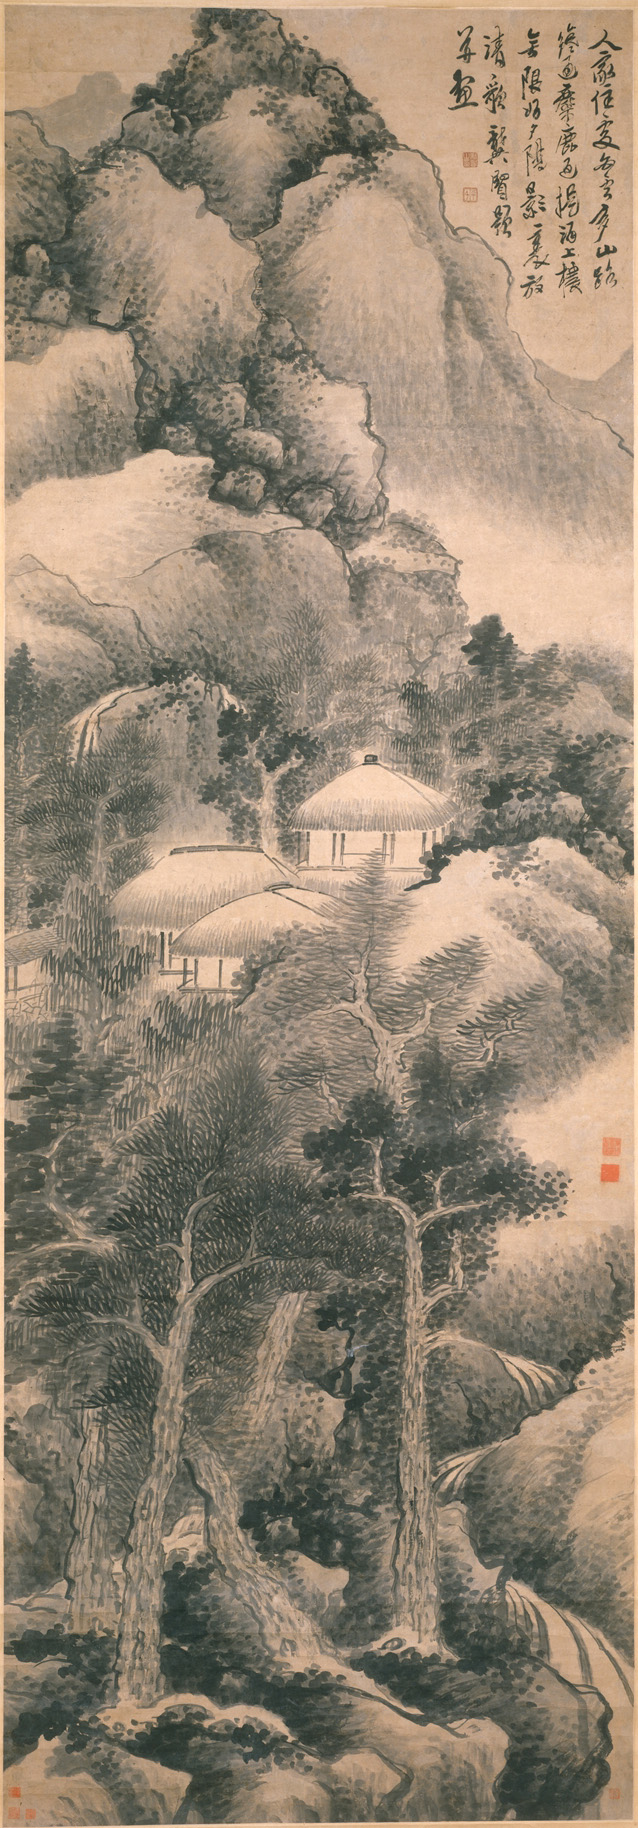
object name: hanging scroll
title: Dwelling among mountains and clouds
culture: chinese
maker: gong xian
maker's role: artist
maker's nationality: chinese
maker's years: 1619-1689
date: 1601-1700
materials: ink, paper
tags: mountains,landscapes